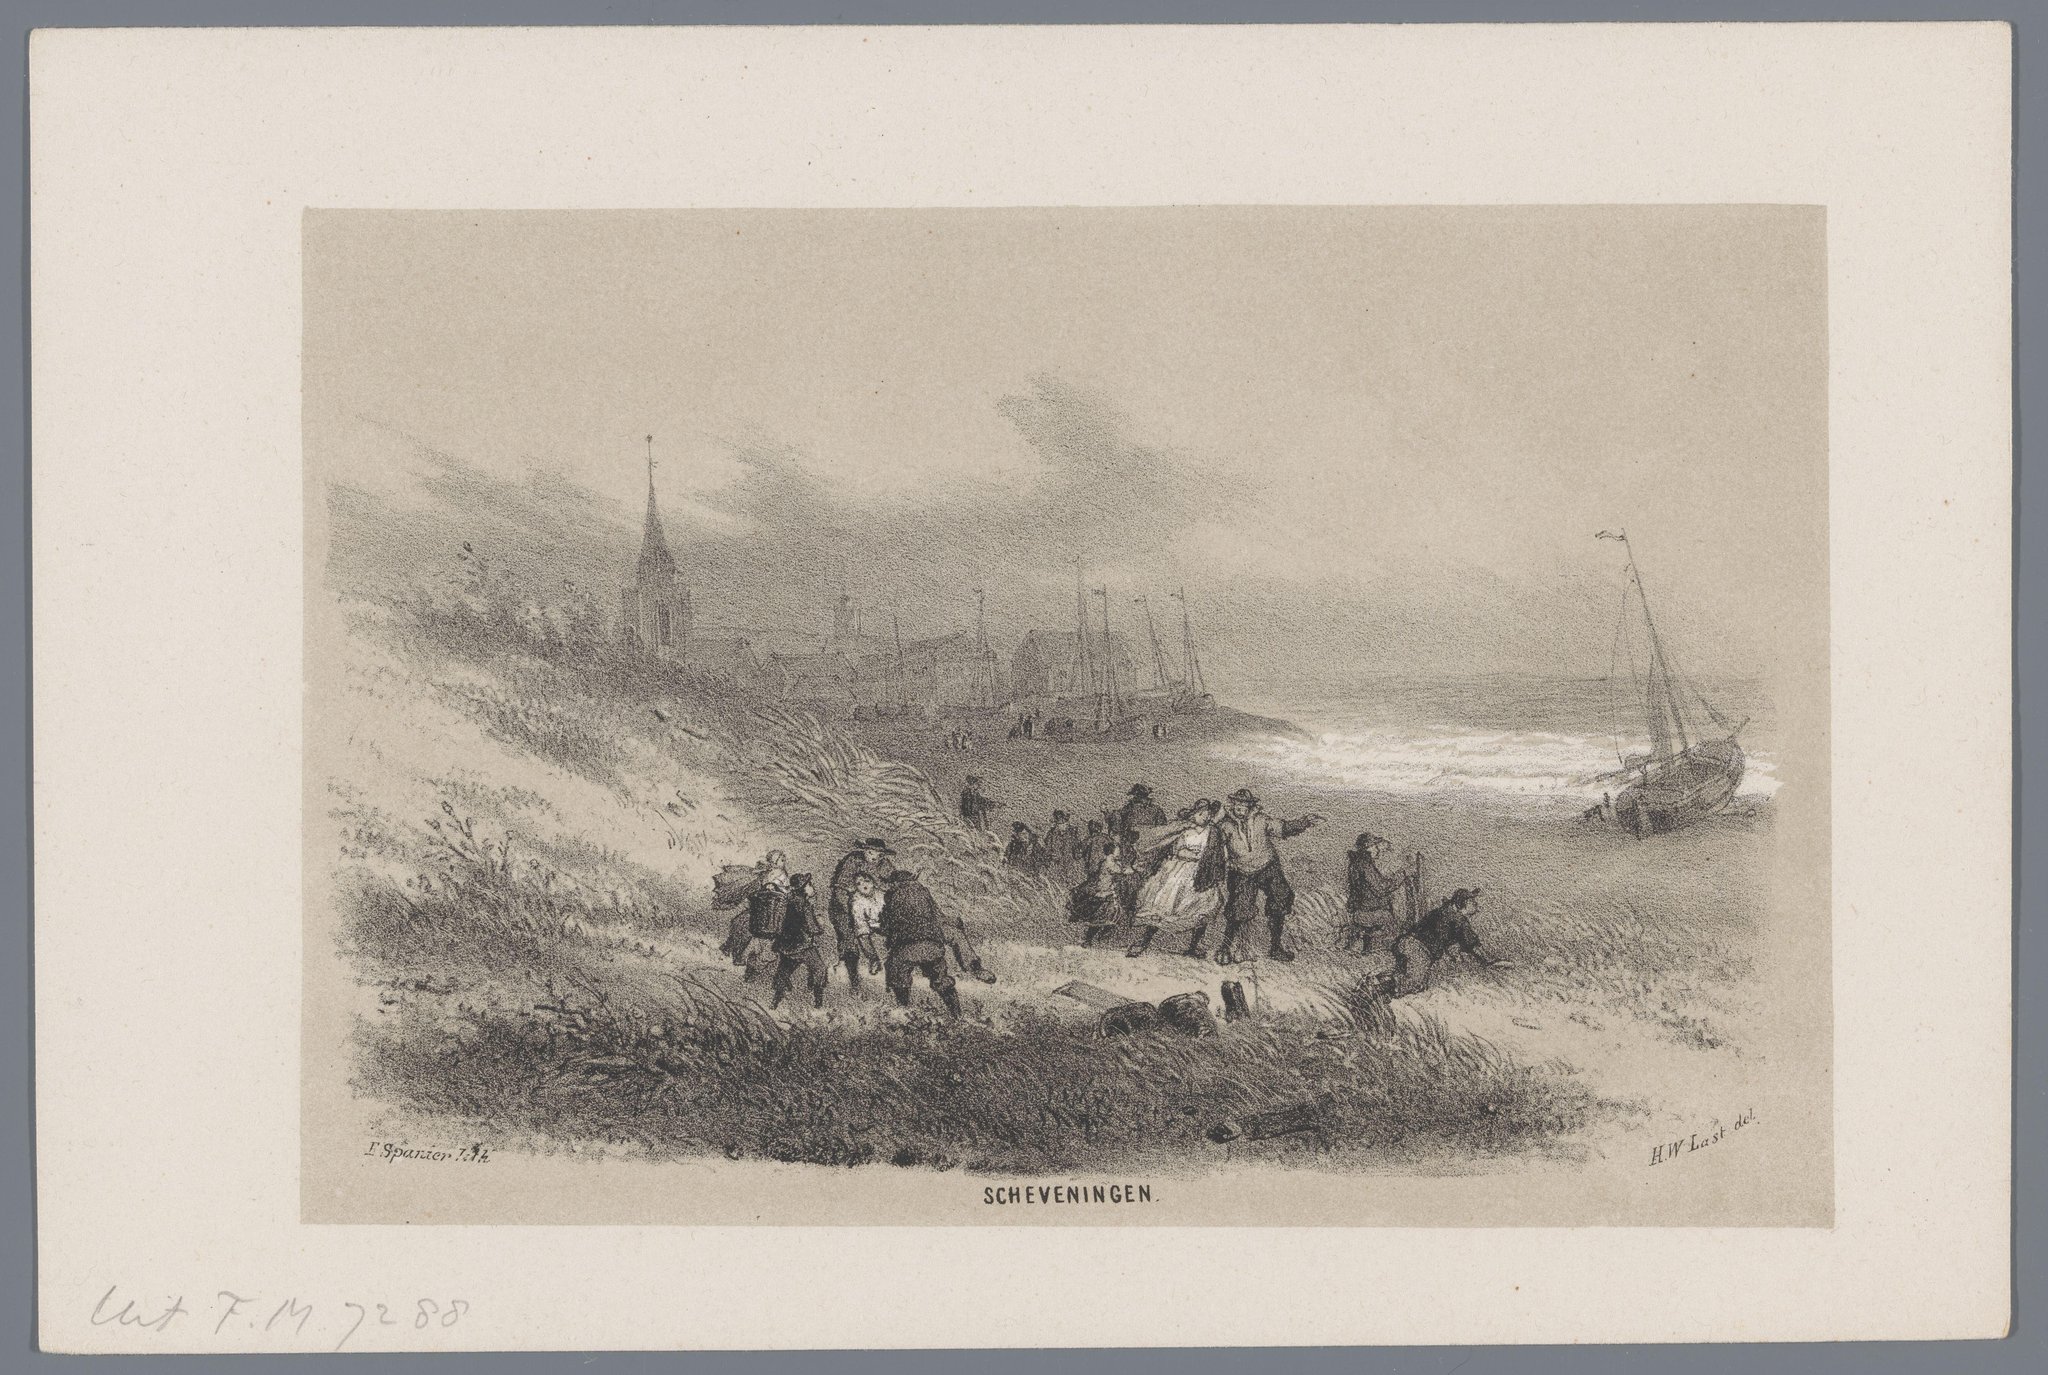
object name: print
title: Album van tien gelithographieerde schetsen, voorstellende Tooneelen van de Verwoesting, Aangerigt door den storm van 28 mei 1860 in het 's Gravenhaagsche Bosch, te Scheveningen, enz.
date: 1860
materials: paper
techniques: tone lithography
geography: the hague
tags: storm at sea, storm on land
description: Volk op de been in de duinen bij Scheveningen, tijdens de storm. Onderdeel van het album met tien losse steendrukken in een papieren omslag met voorstellingen van de schade aangericht door de 'Pinksterstorm' van 28 mei 1860 in het Haagse Bos en omgeving.